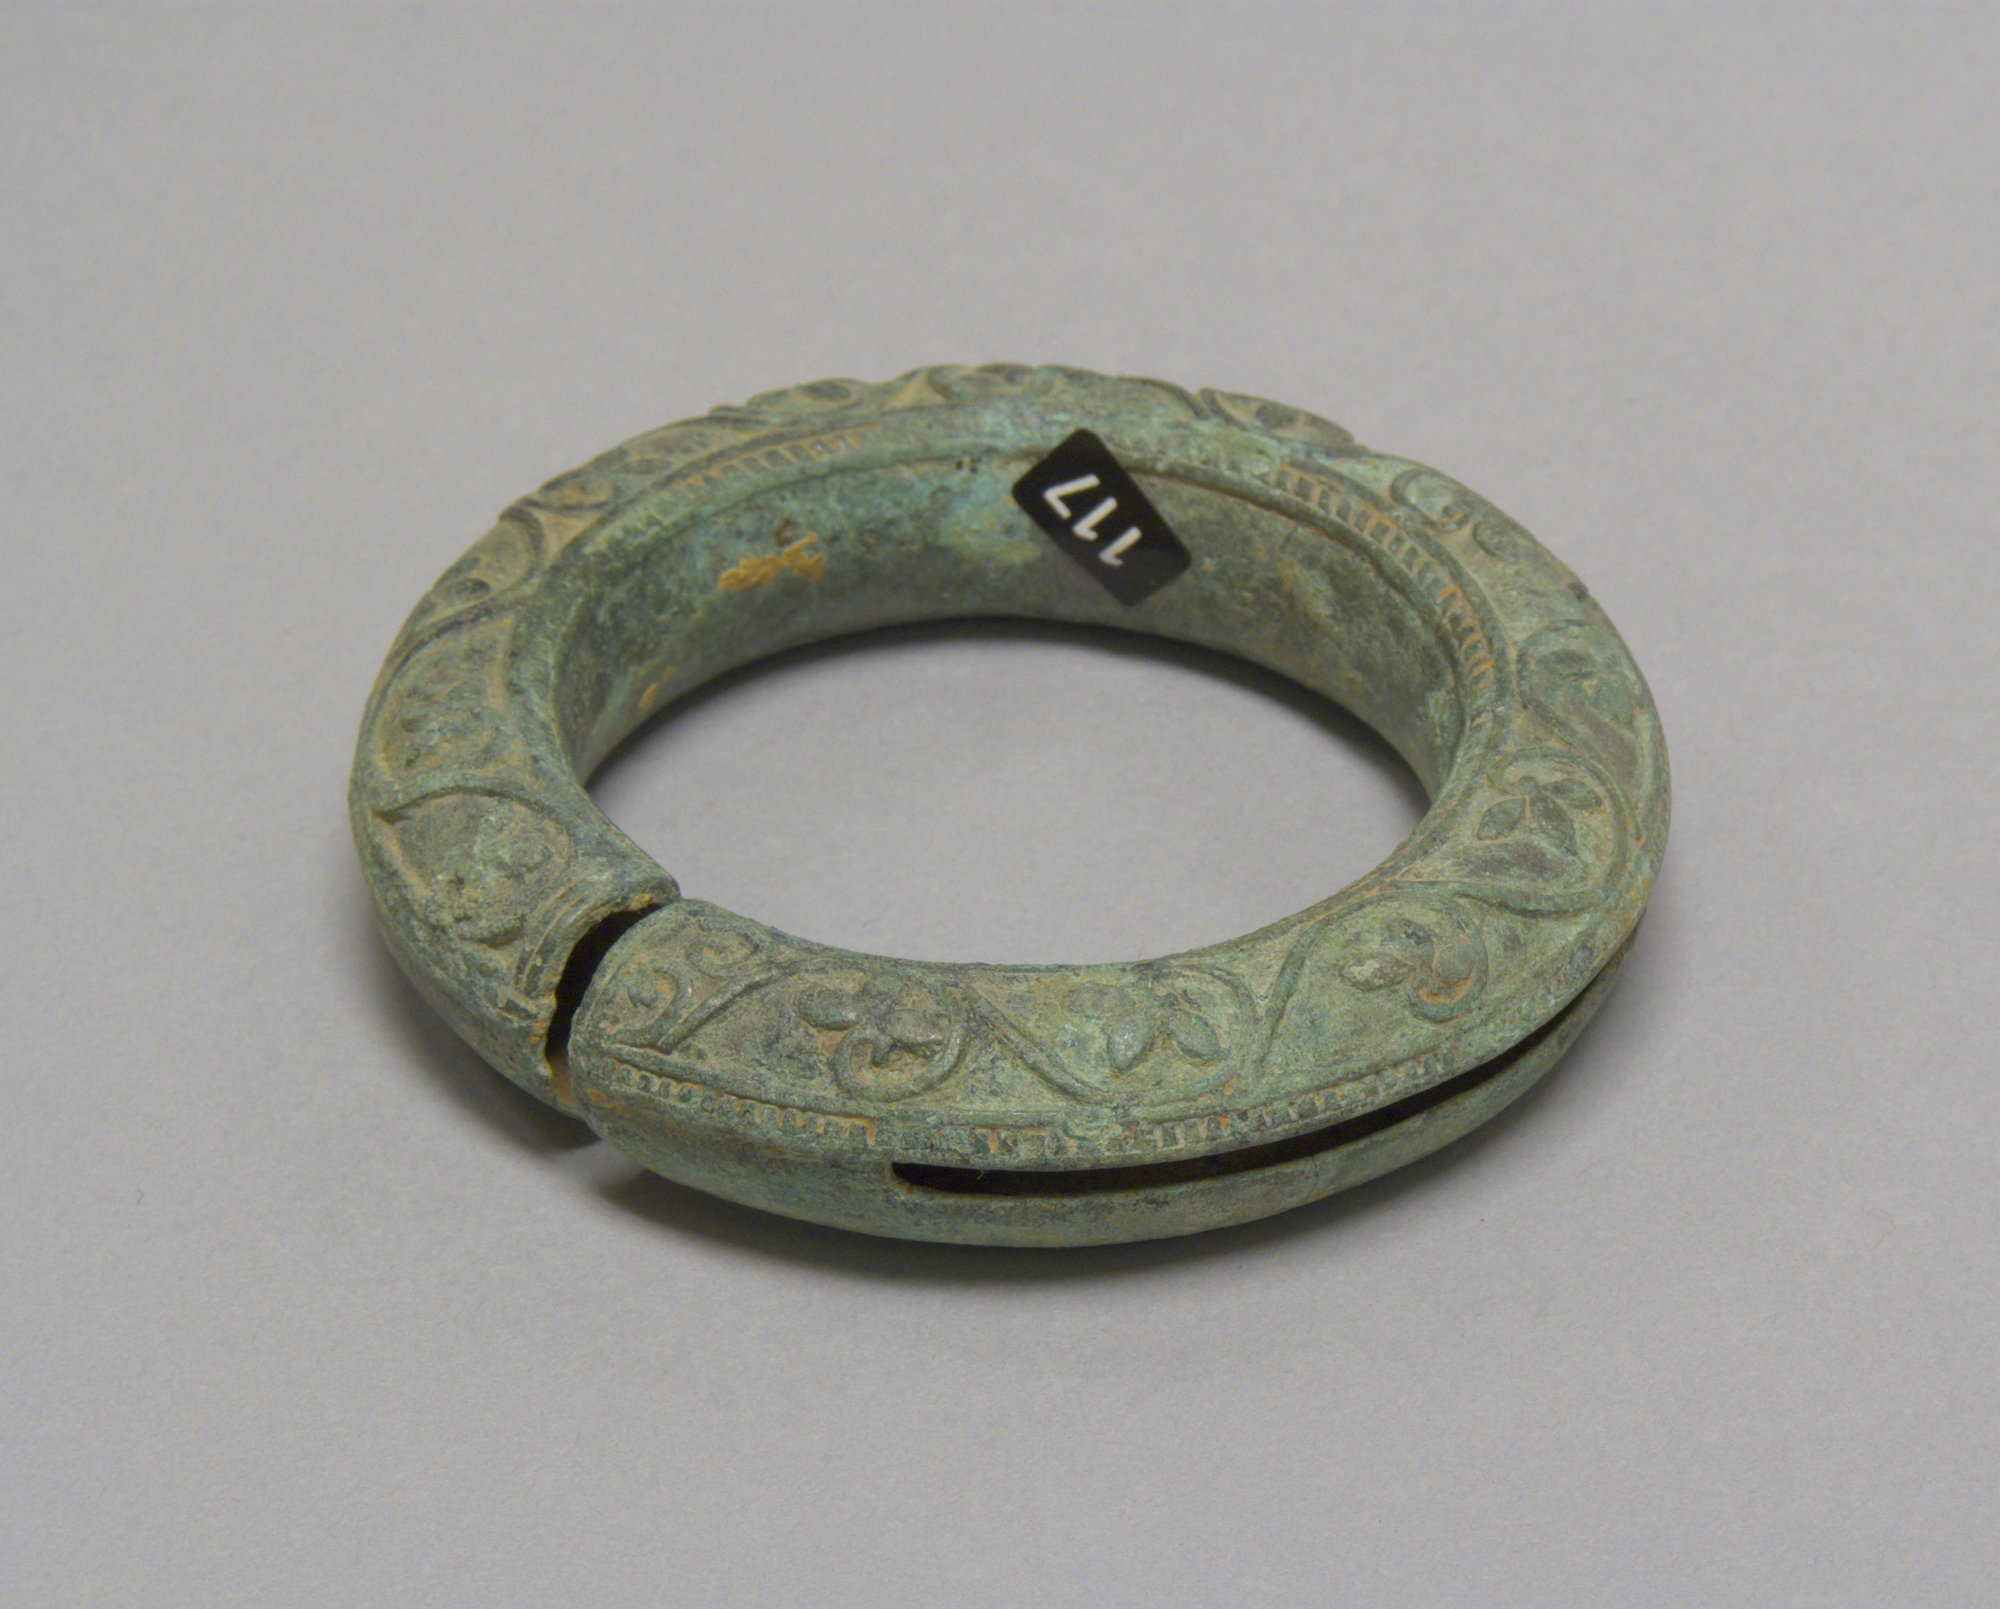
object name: bracelet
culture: thai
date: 500 BCE-300 CE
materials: bronze